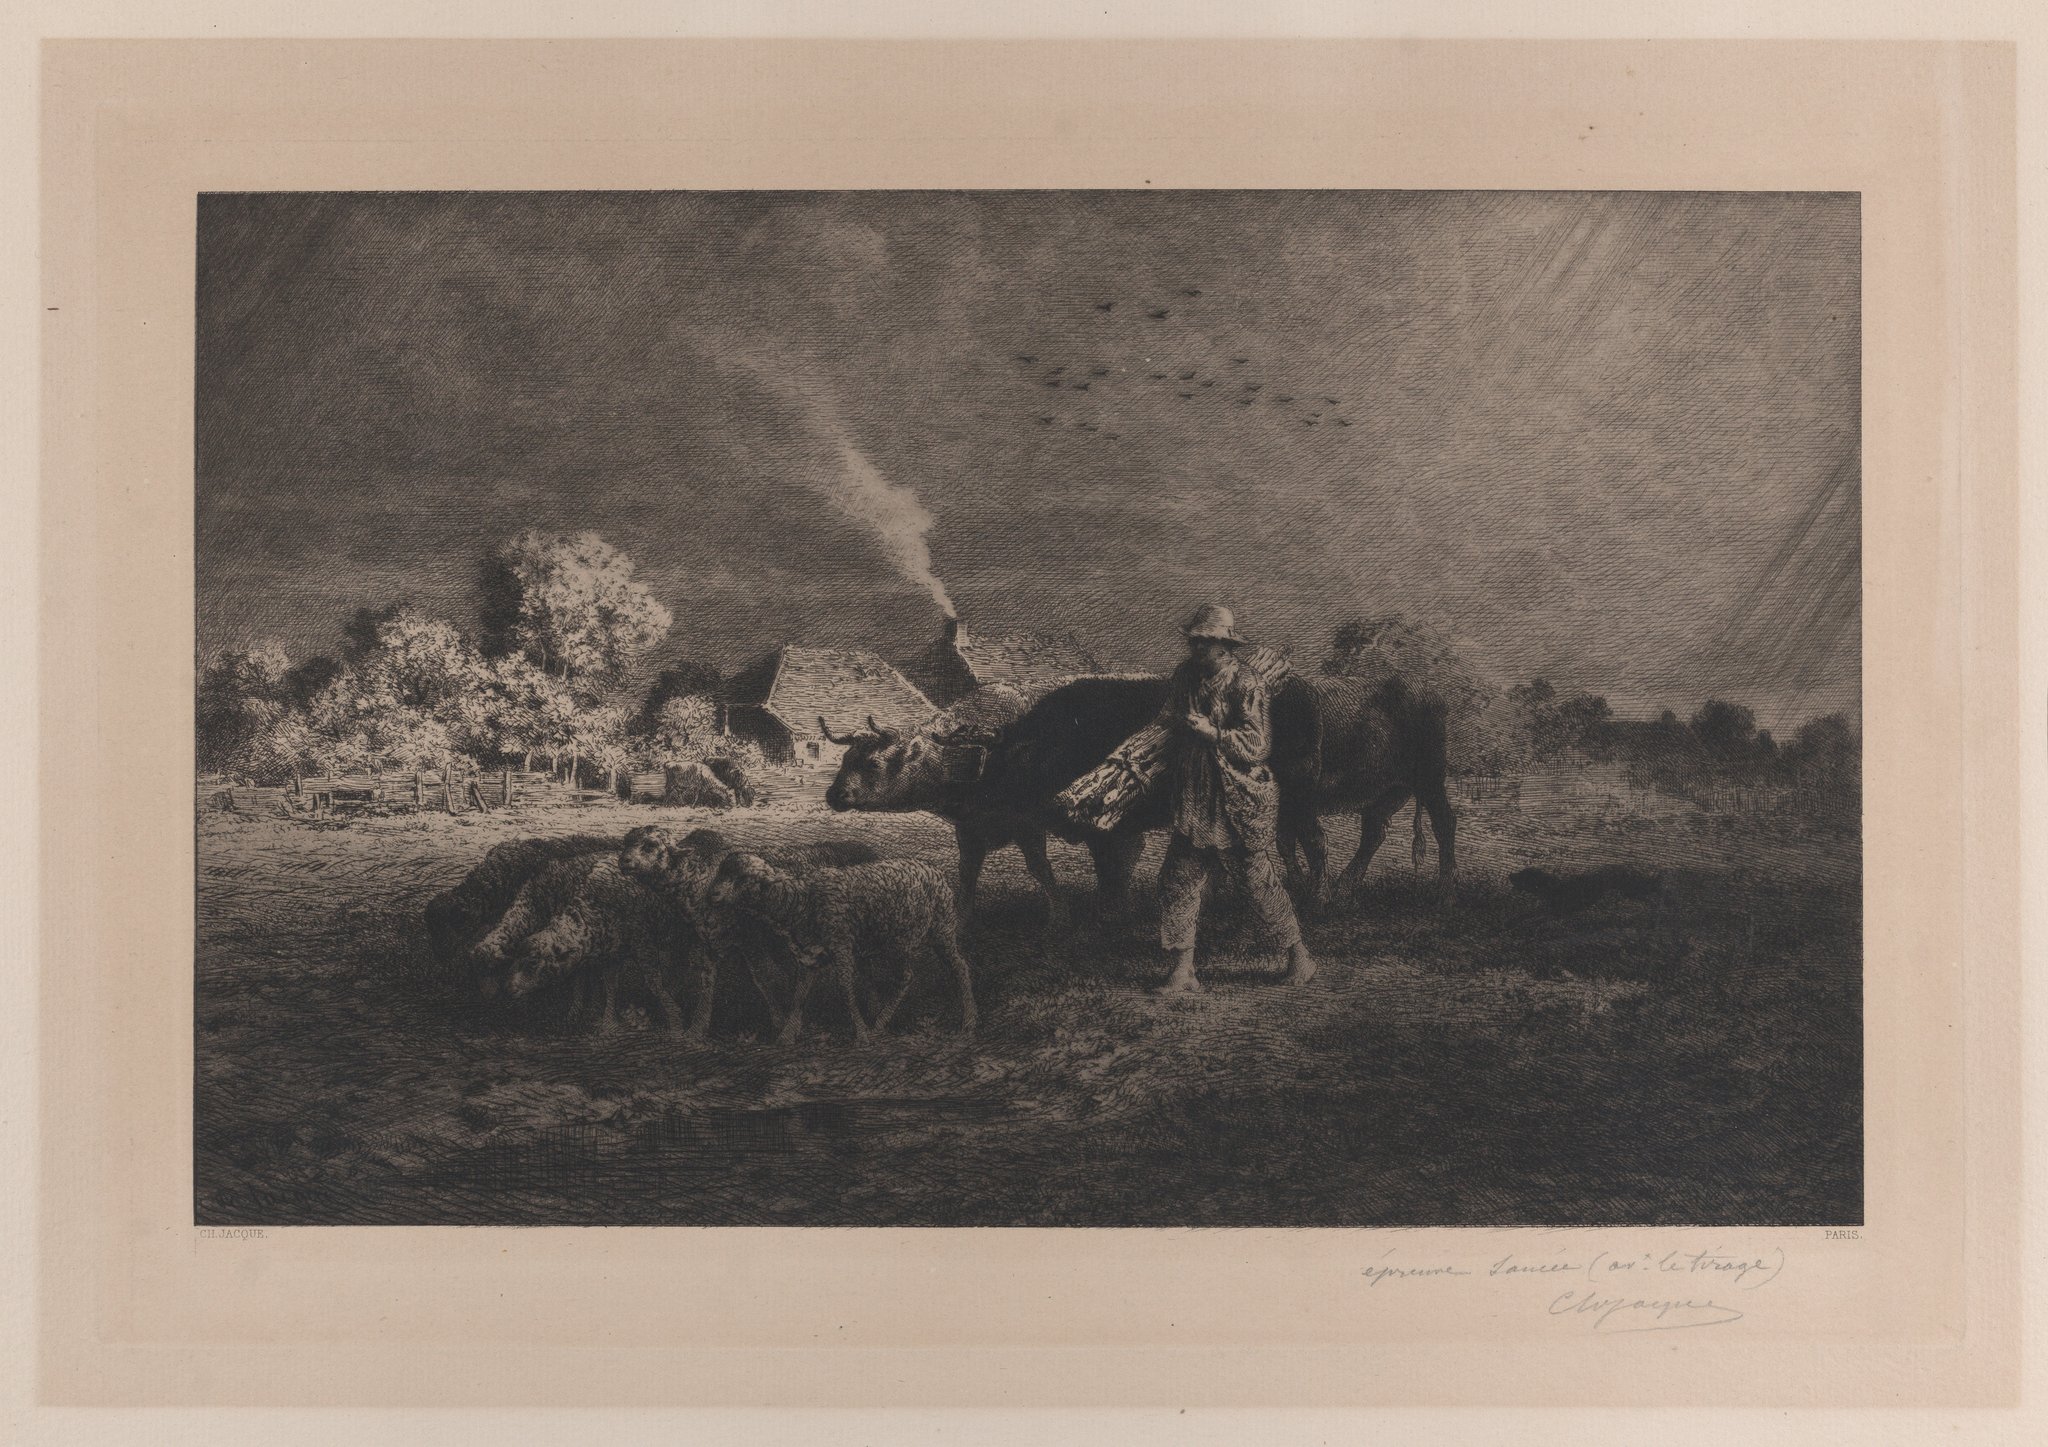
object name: print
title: The Storm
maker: charles émile jacque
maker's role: artist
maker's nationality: french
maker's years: 1813-1894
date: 1865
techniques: engraving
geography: paris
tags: men,cows,sheep,storms